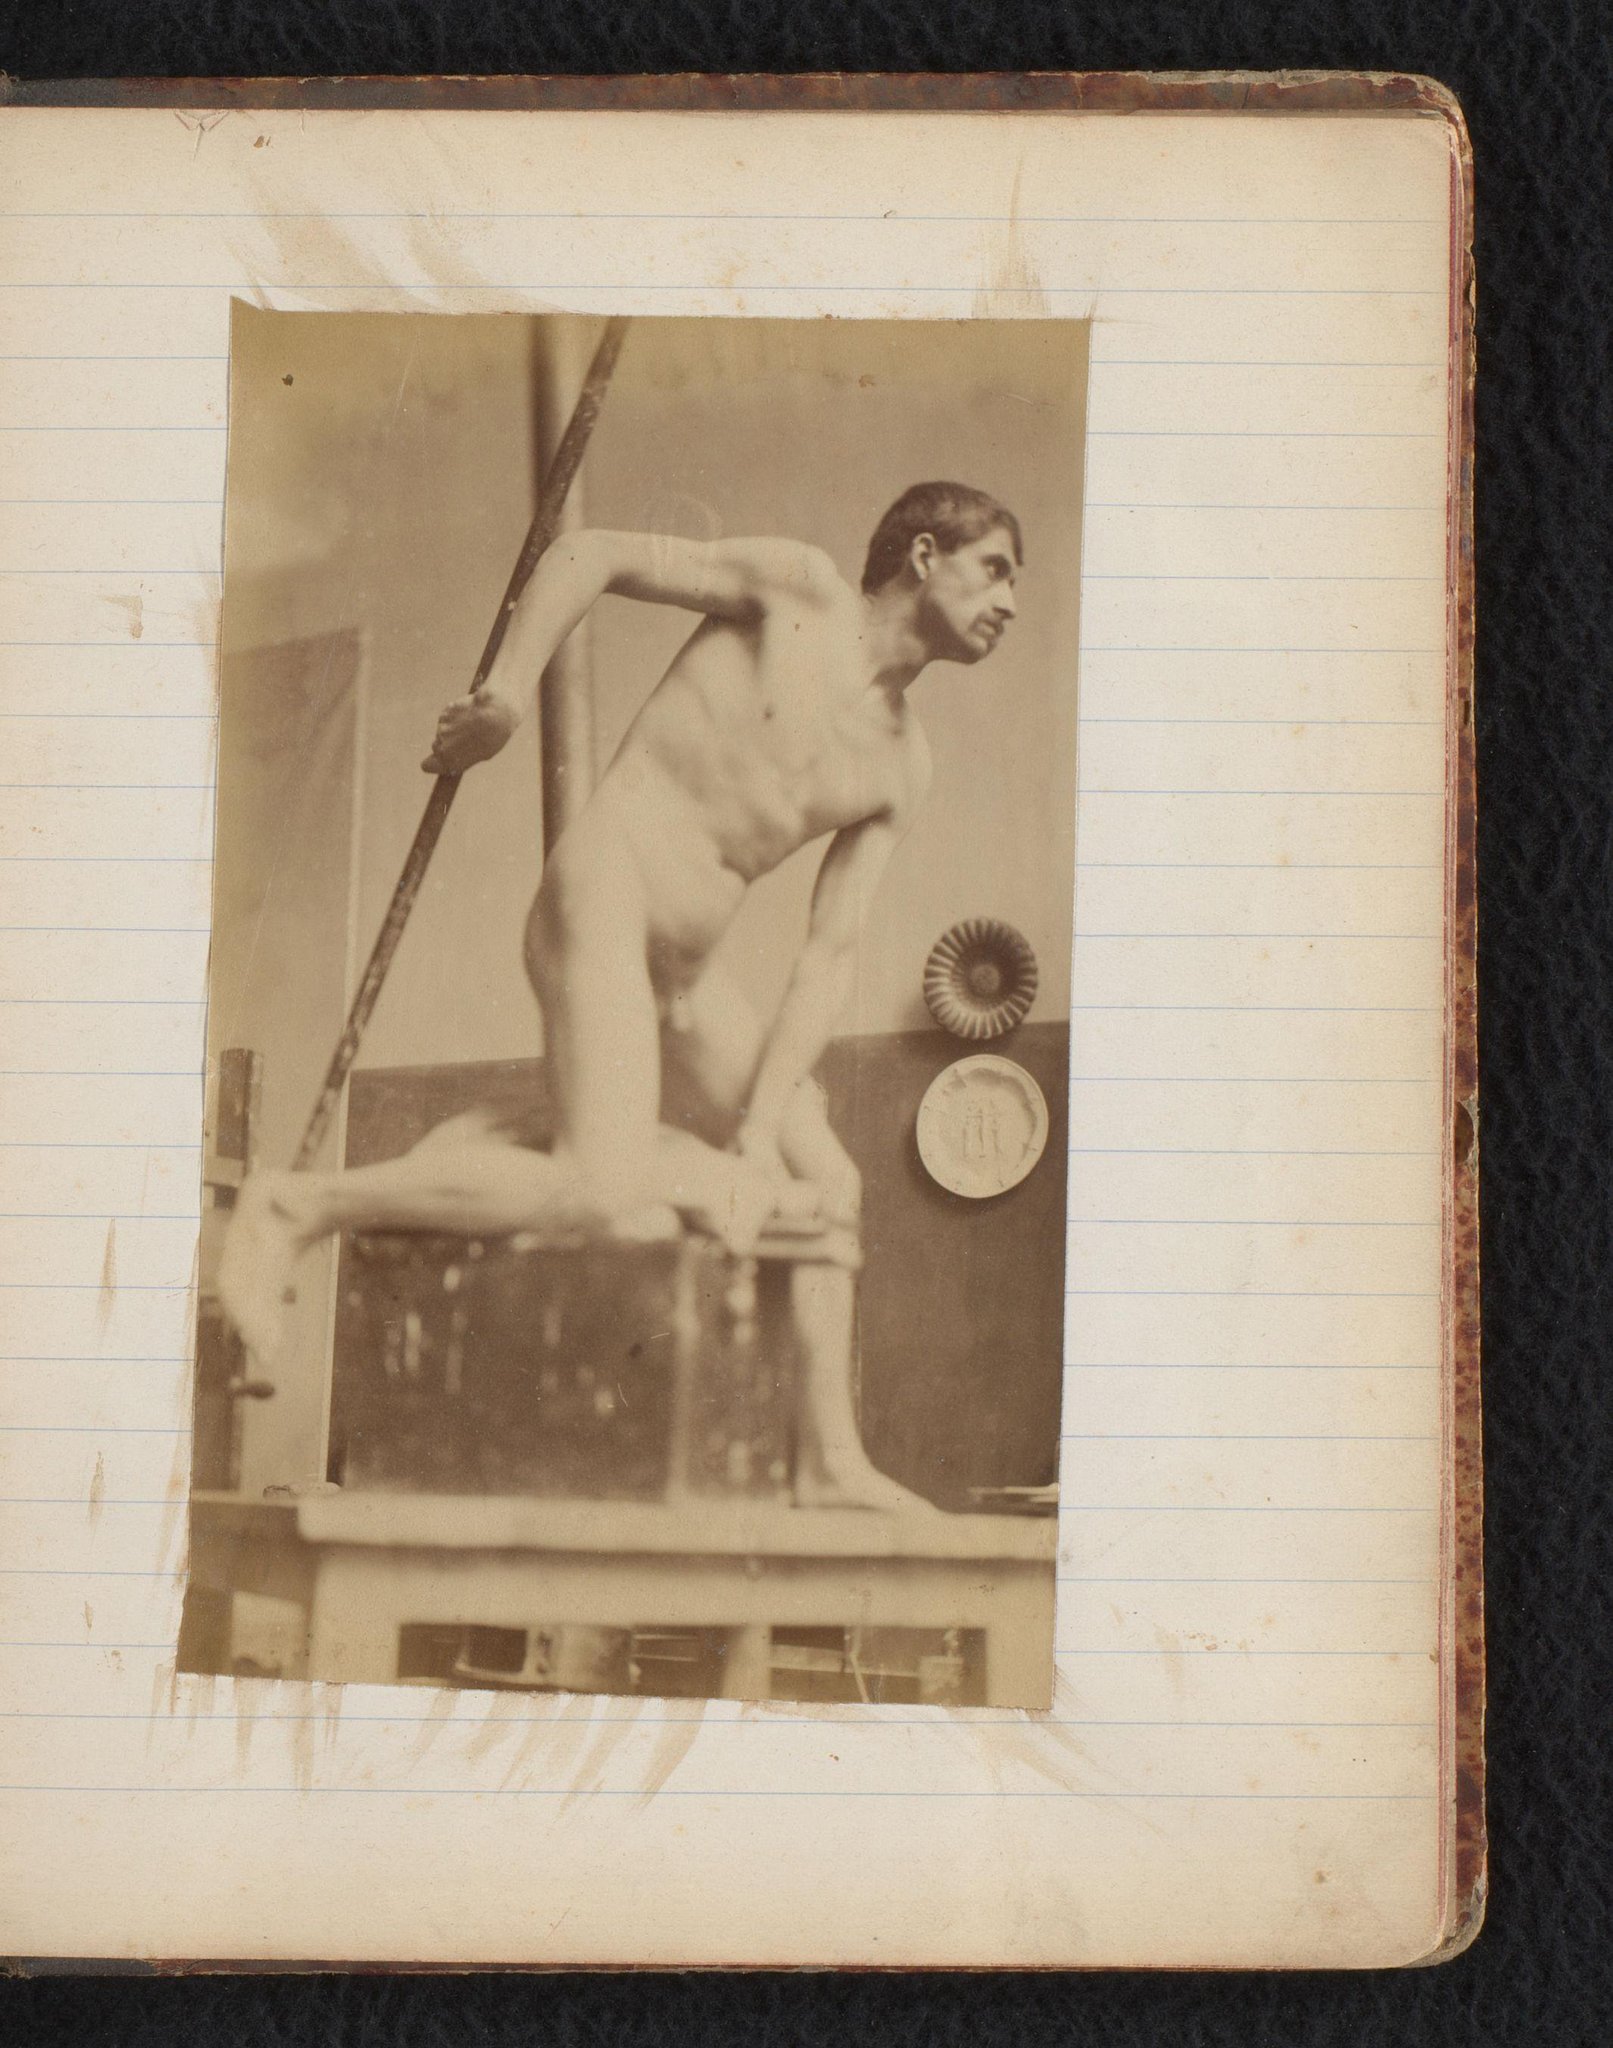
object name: album leaf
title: Studie van een mannelijk naaktmodel, met speer in de hand, in het atelier van Jacques de Lalaing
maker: jacques lalaing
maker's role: painter, sculptor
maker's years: 1858-1917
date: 1883-1914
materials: photographic support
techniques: albumen print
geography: brussels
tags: the (nude) human figure; 'corpo humano' (ripa) (+ sideview, profile), adult man, artist (in general) working from nude model